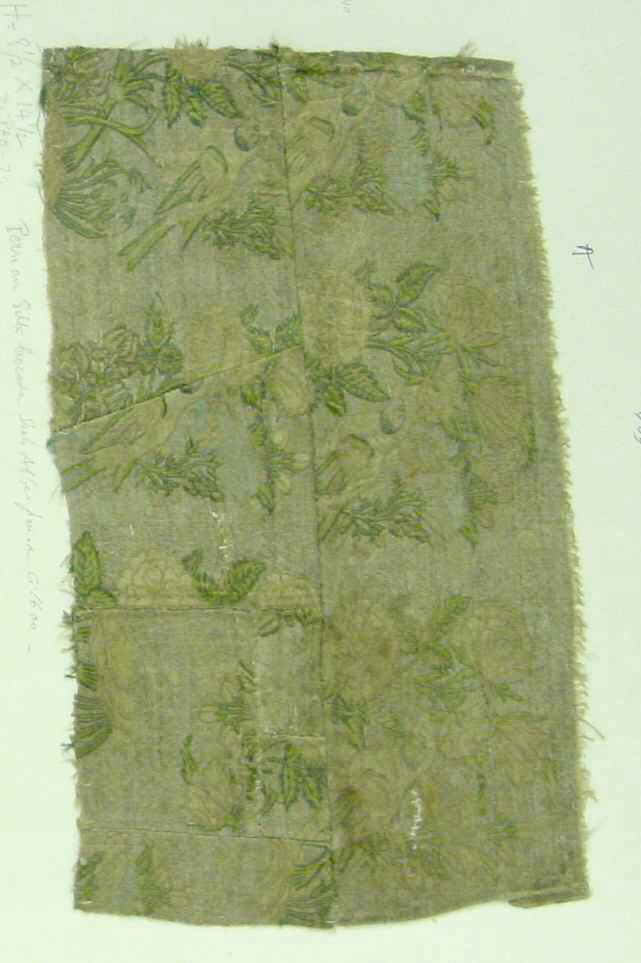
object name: textile fragment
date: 1601-1700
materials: metal thread, silk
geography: iran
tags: flowers